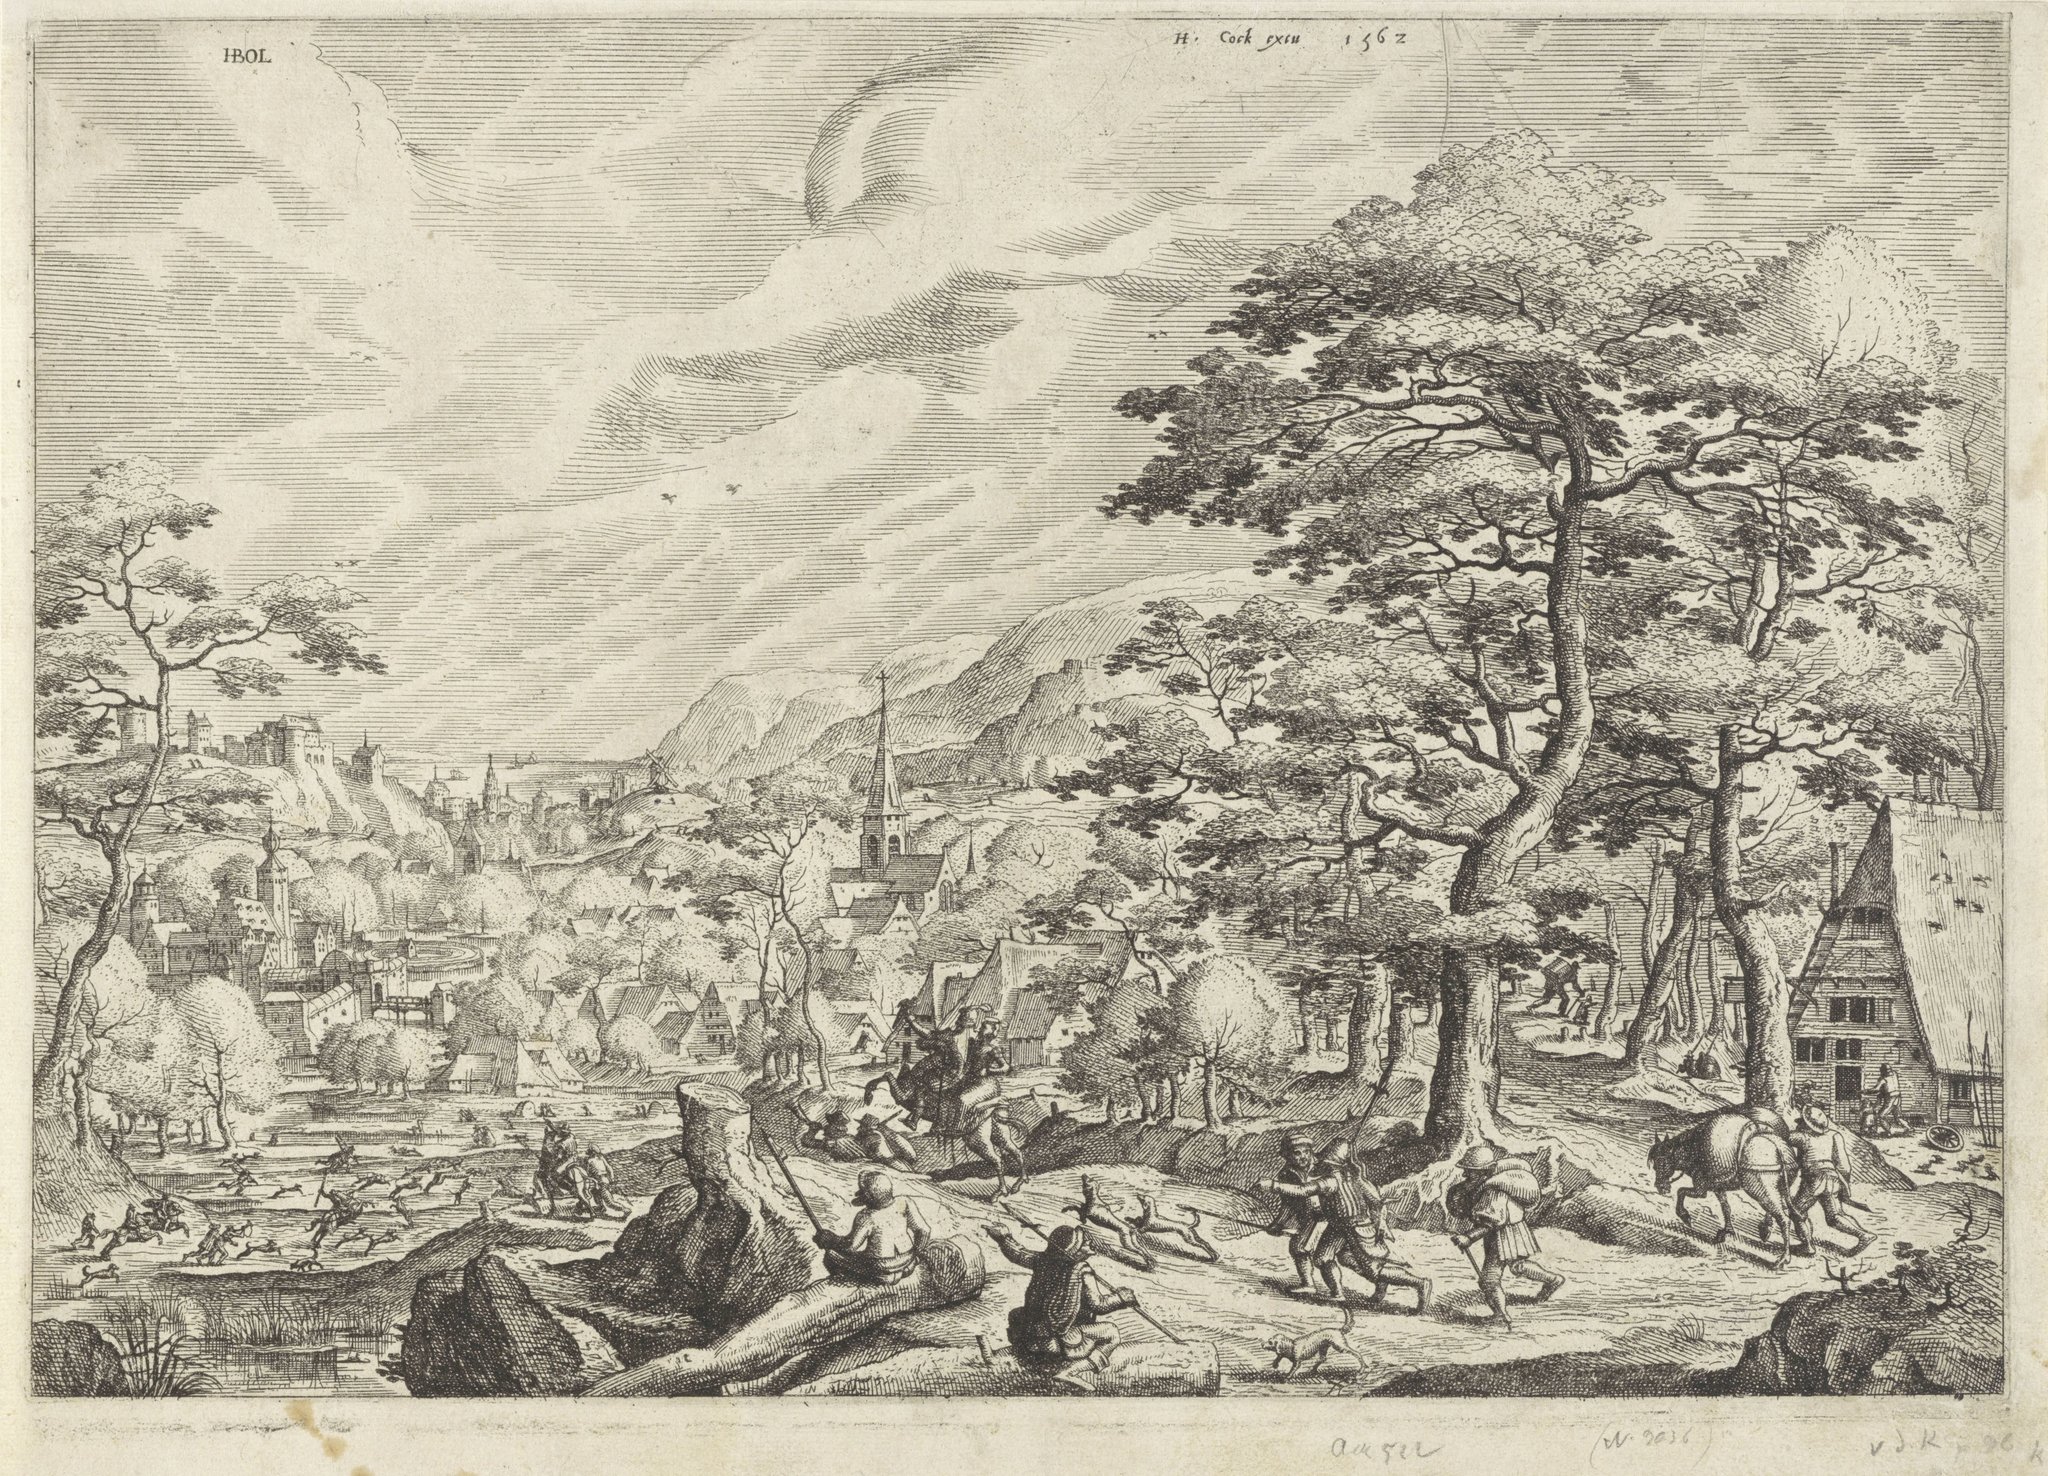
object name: print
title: Rivierlandschappen met bebouwing en figuren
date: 1562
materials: paper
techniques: etching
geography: low countries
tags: predatory birds: falcon, bird hunting (+ out of doors (sports ~ animals)), hunting dogs, village, mountains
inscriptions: collector's mark: Lugt 2228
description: In een bergachtig landschap met enkele waterpartijen jagen meerdere mannen aan de rand van een dorp. Ze worden vergezeld door jachthonden. De ruiter vooraan heeft een valk op zijn hand. In de verte staat een kerk.